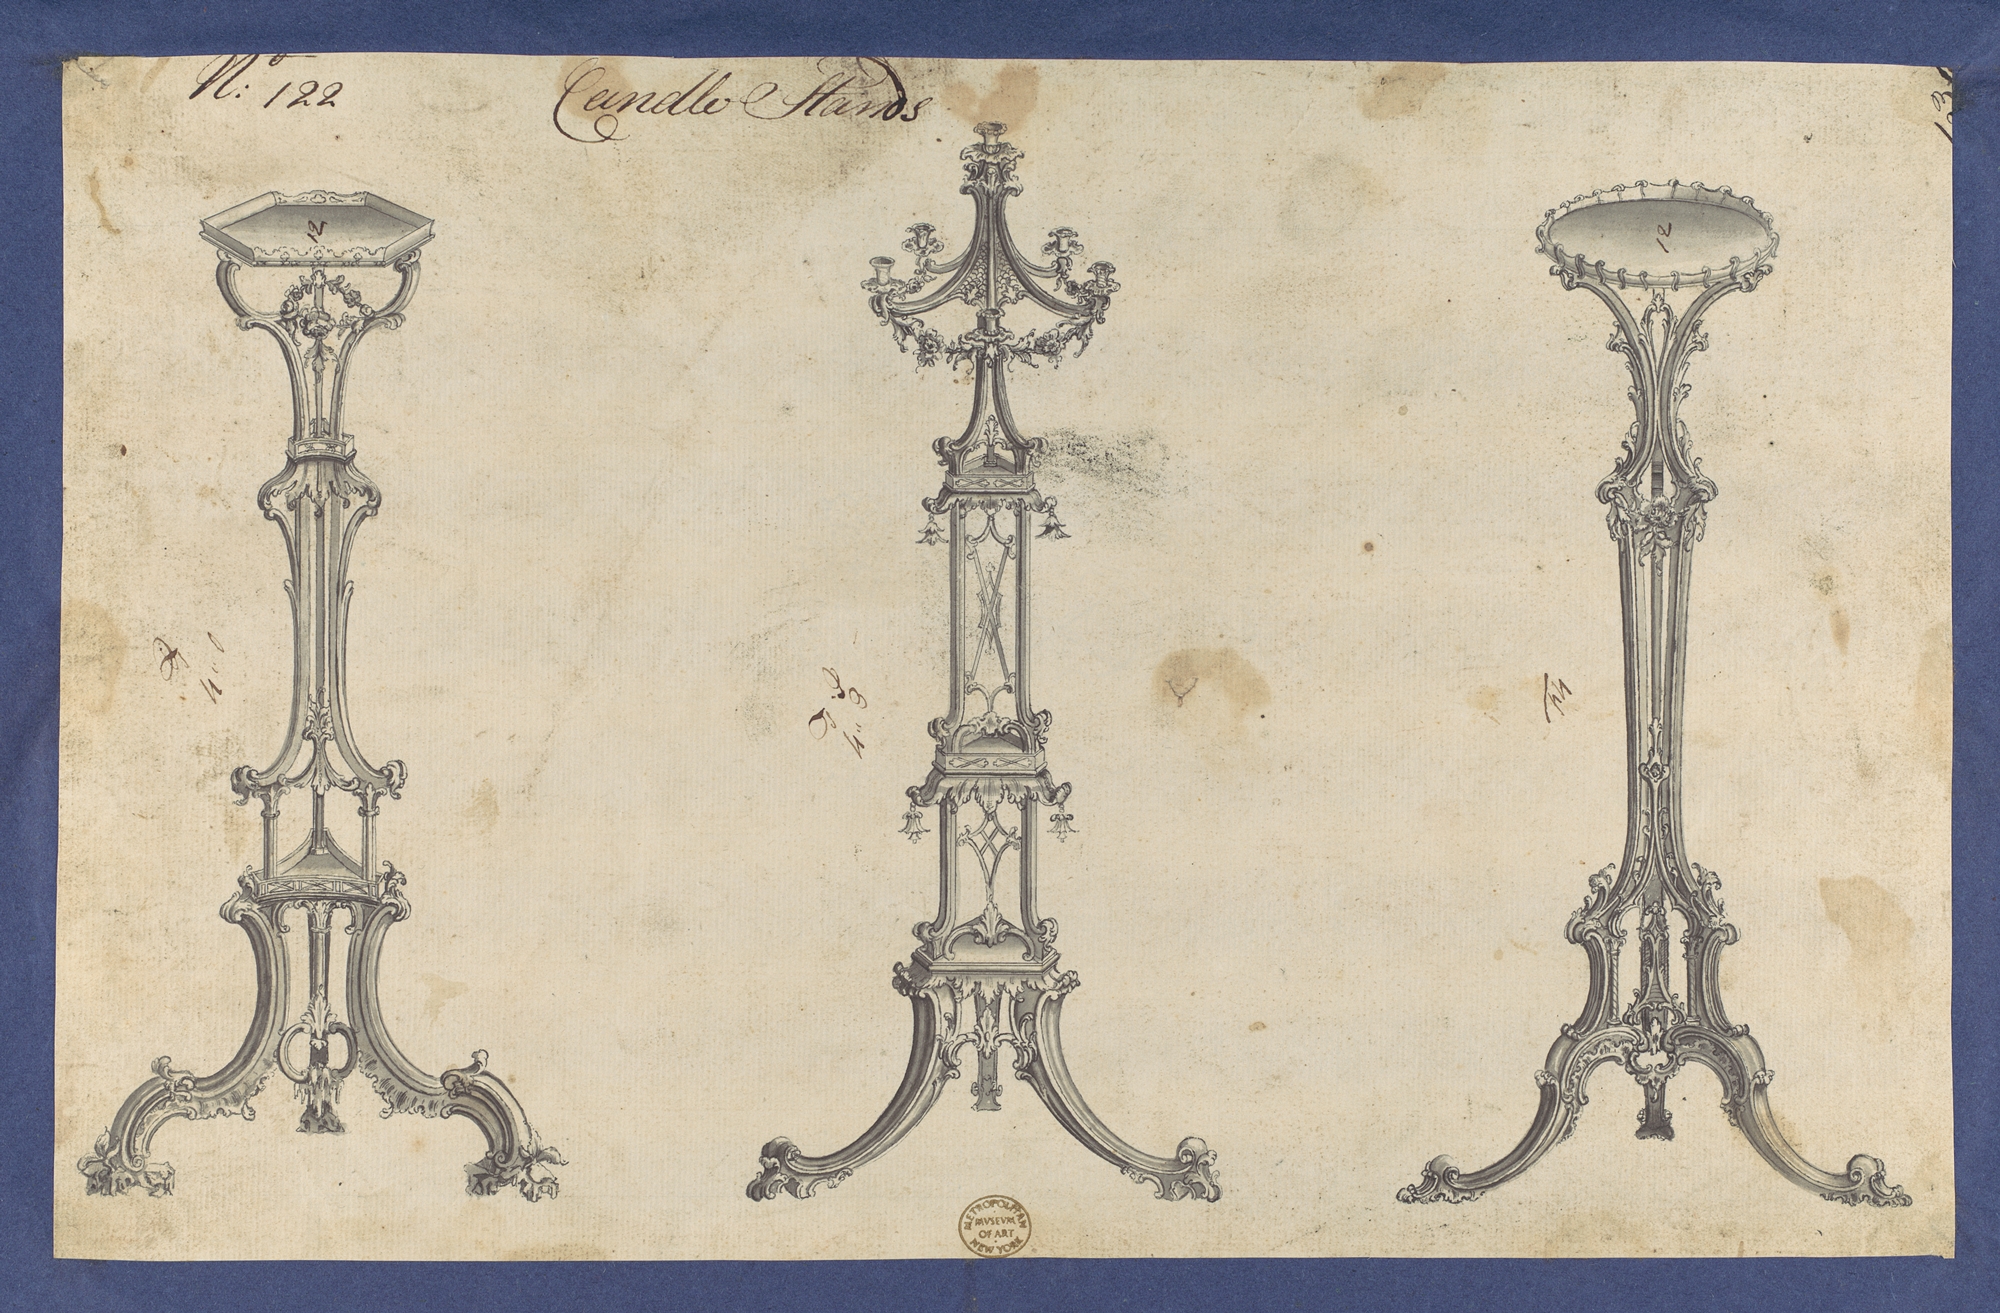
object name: drawing ornament architecture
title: Candle Stands, in Chippendale Drawings, Vol. I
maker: thomas chippendale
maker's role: artist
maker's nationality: british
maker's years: 1718-1779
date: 1753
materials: ink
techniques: wash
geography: london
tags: furniture